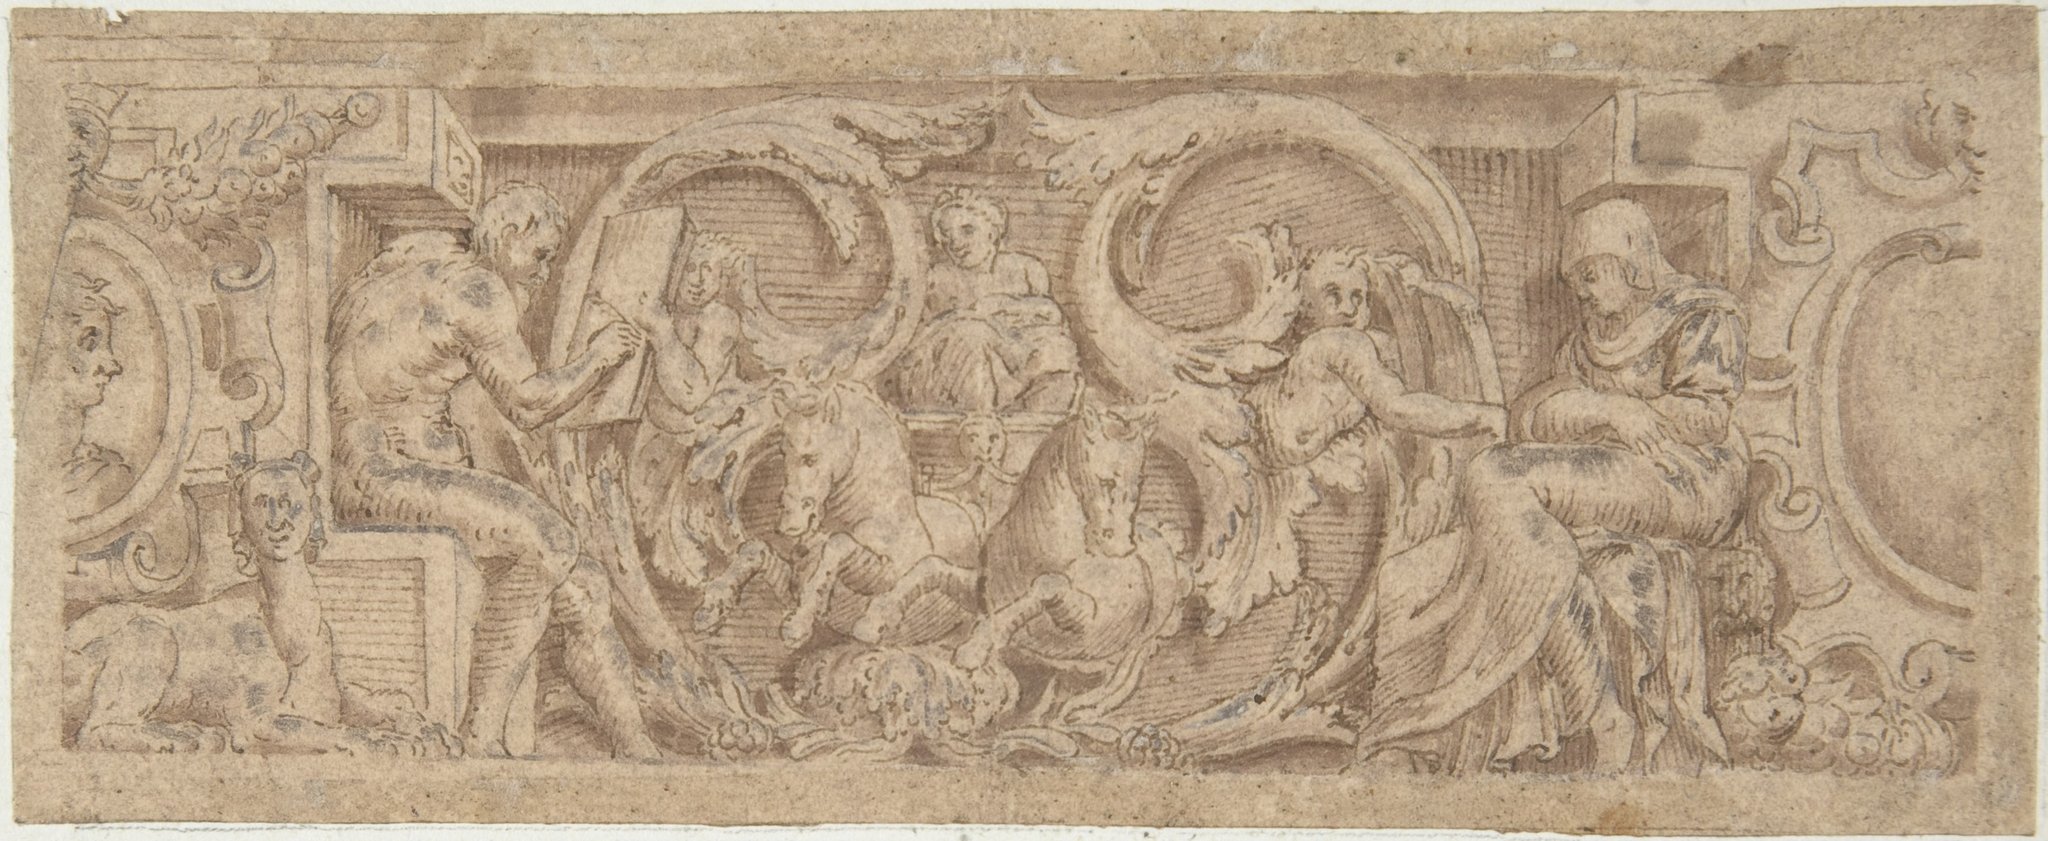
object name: drawing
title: Figures, Horses, and Sphinx Entwined in Foliage and Strapwork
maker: anonymous, german, 19th century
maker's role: artist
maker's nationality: german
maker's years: 1800-1899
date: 1801-1900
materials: ink, paper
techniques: brush, heightening, inlay, pen, wash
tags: men,women,sphinx,horses,leaves